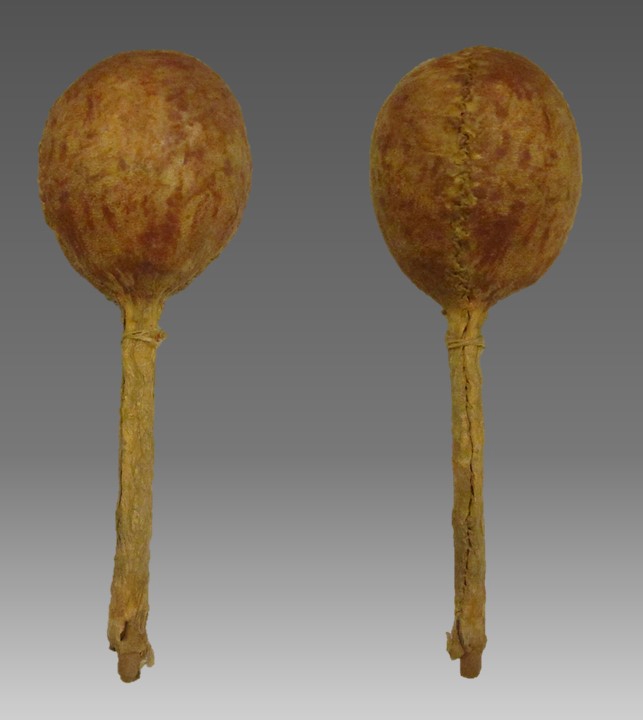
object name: rattle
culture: native american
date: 1801-1900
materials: wood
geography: united states